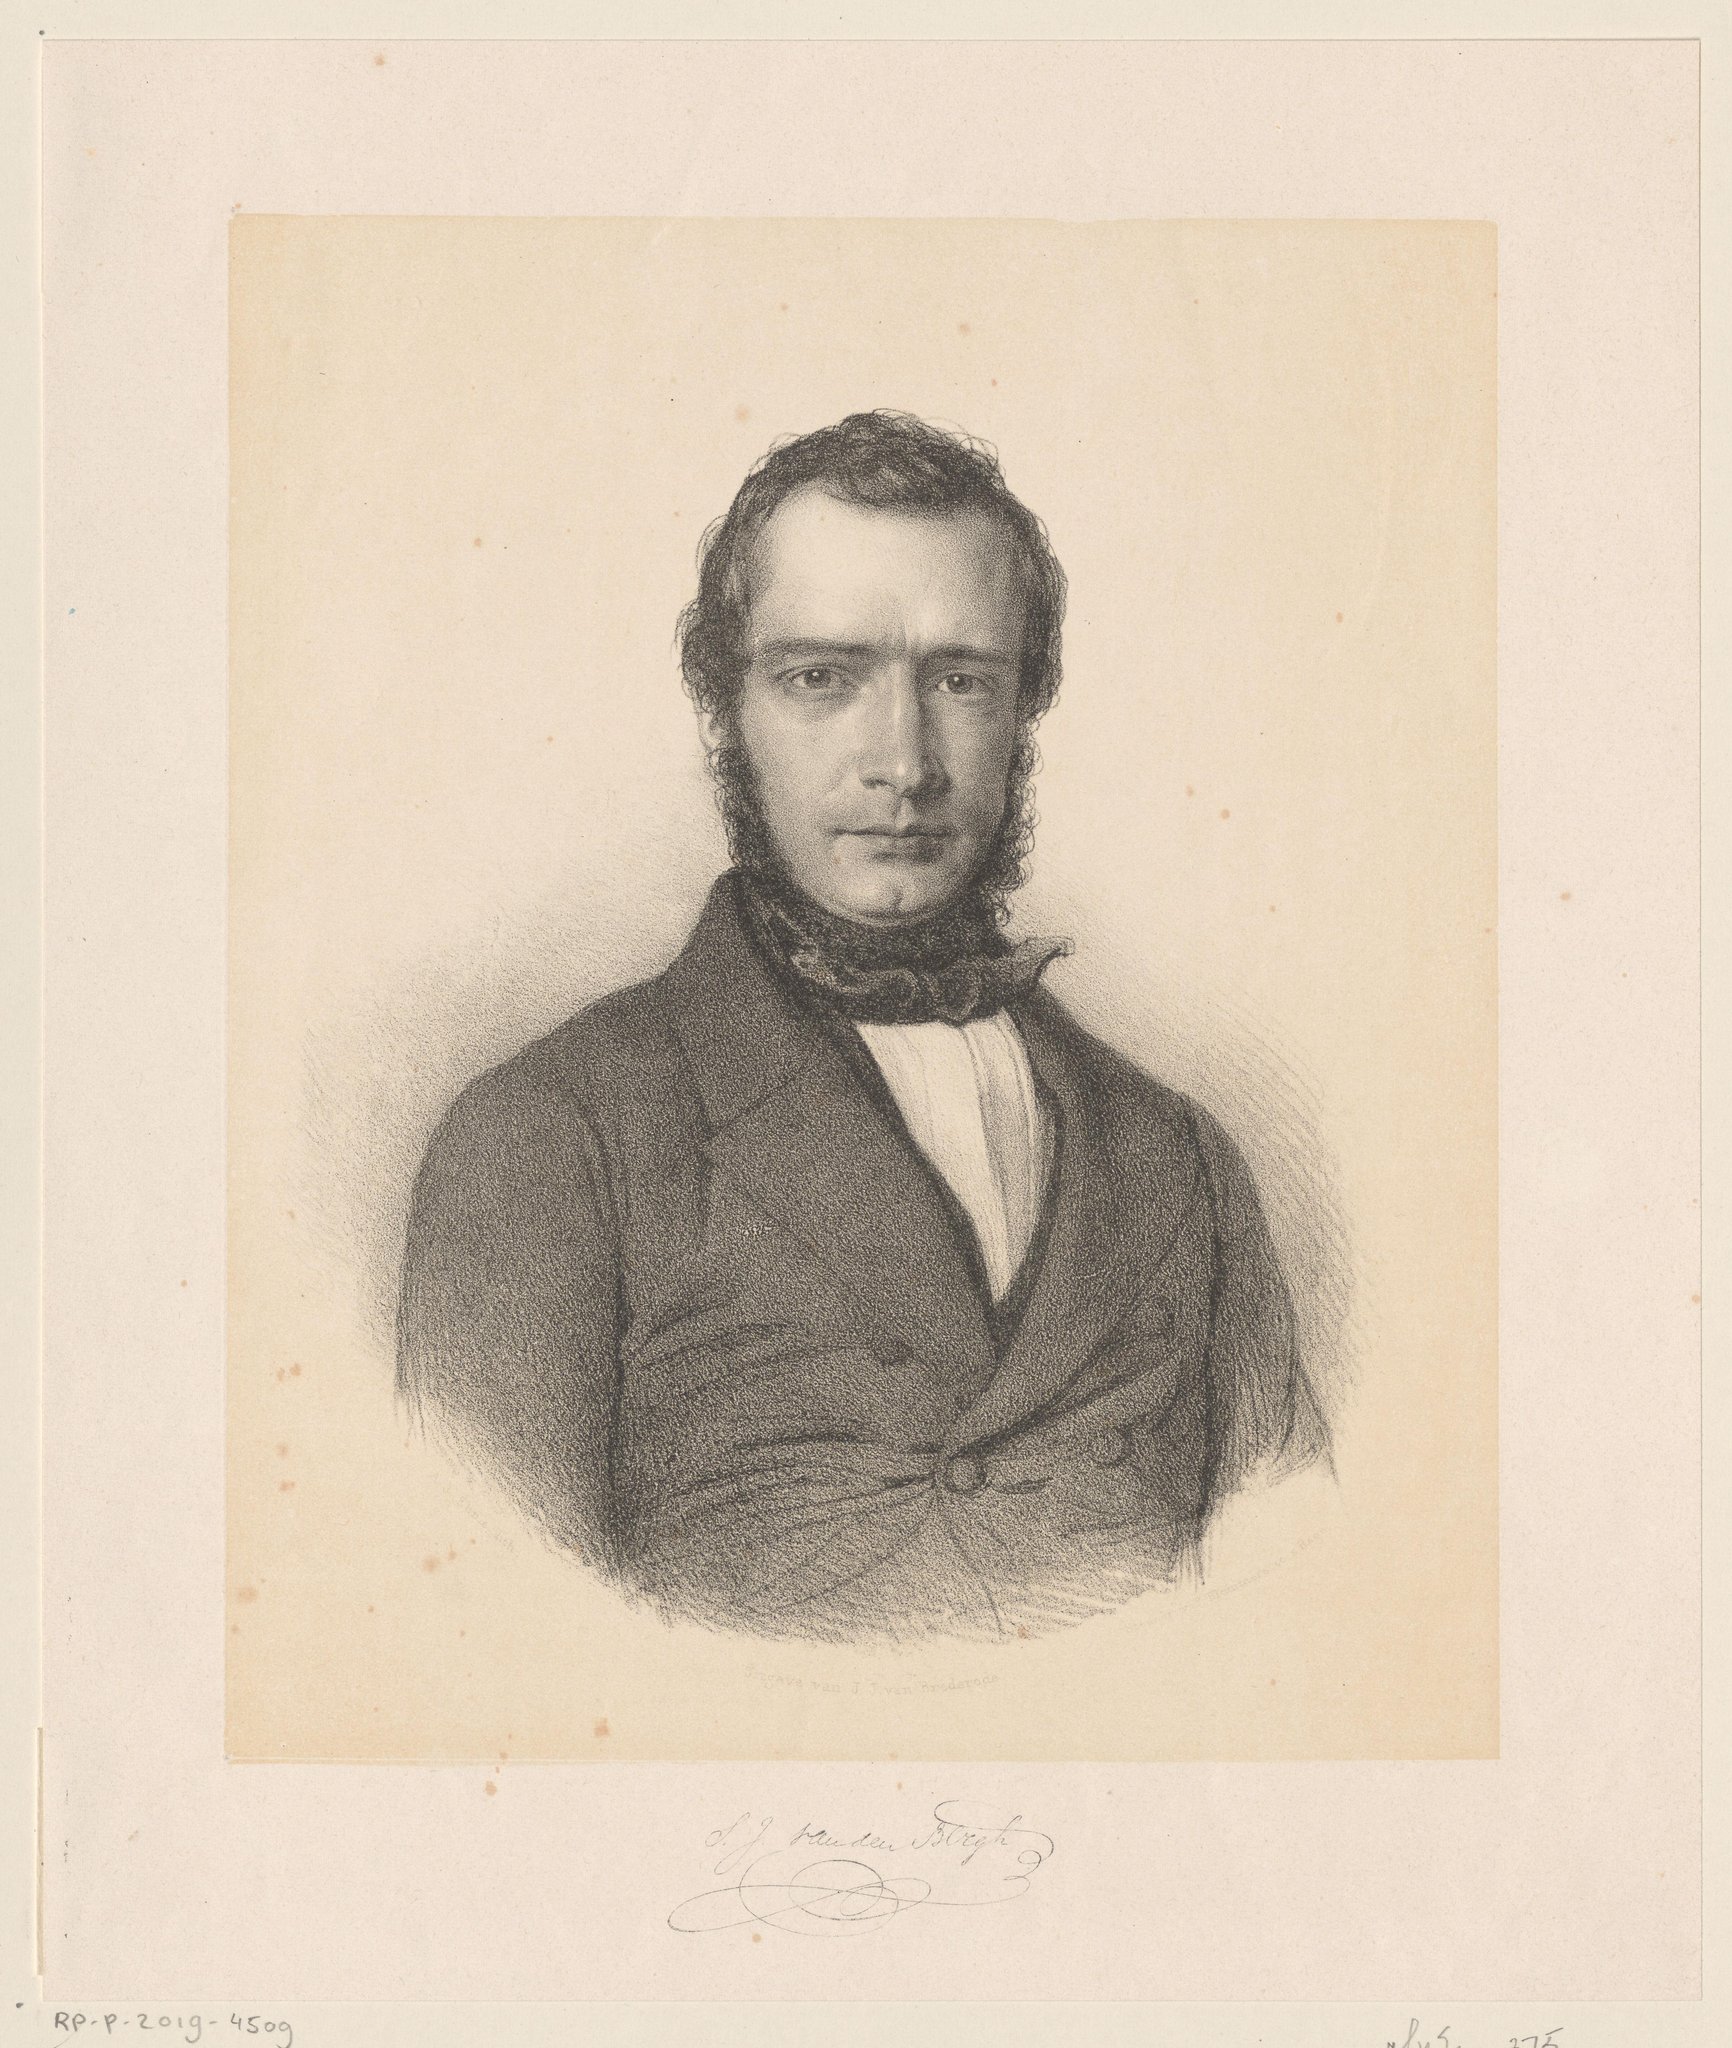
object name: print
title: Portret van Samuel Johannes van den Bergh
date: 1852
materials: paper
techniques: tone lithography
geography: haarlem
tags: the hague, samuel johannes van den bergh, historical persons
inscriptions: collector's mark: Lugt 2228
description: Prent verschenen in het 'Album der schoone kunsten' van 1852.